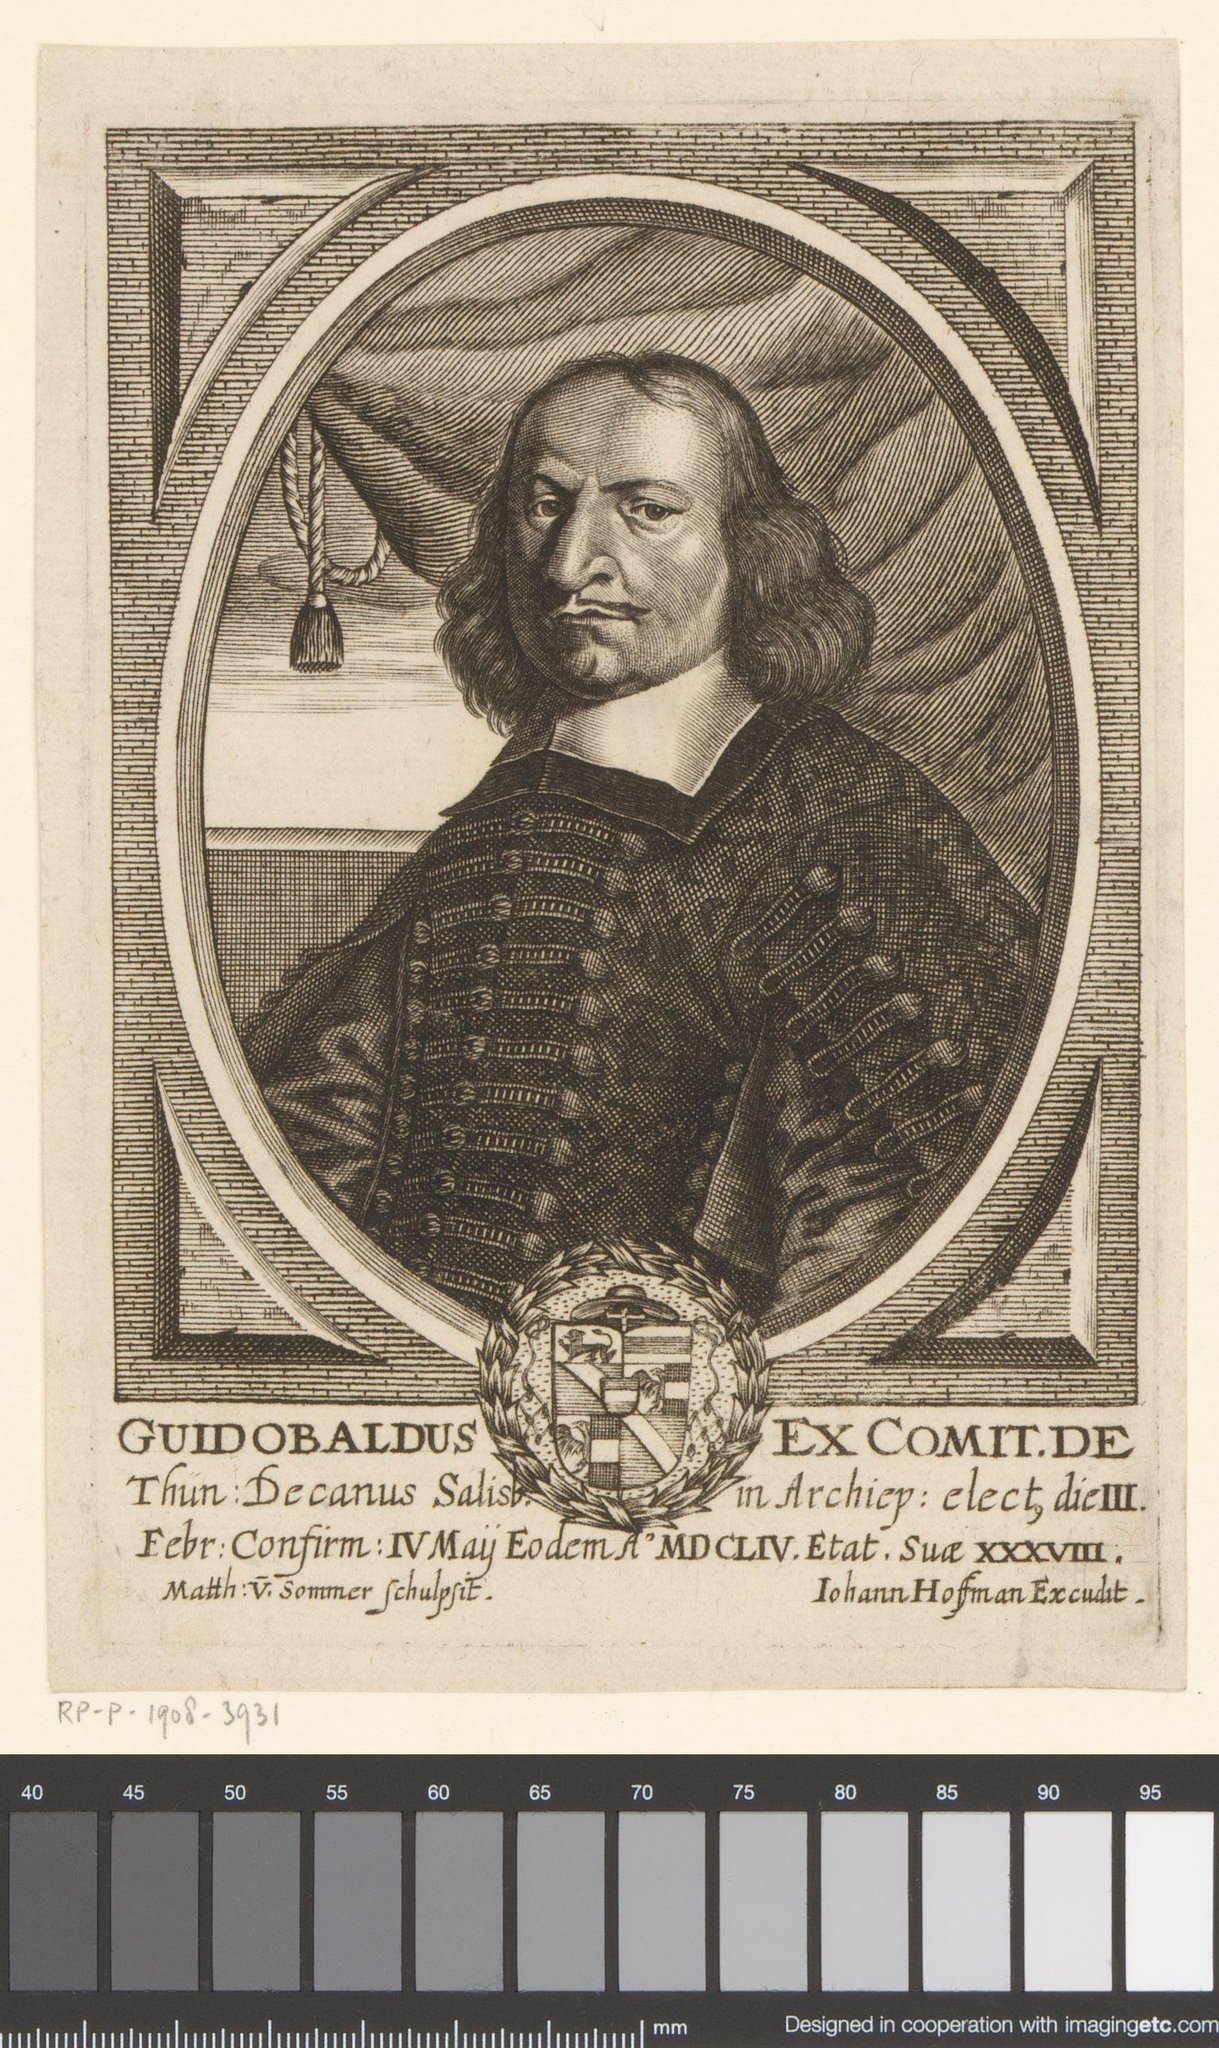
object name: print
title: Portret van Guidobald von Thun und Hohenstein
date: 1654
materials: paper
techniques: engraving, etching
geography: nuremberg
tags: clergyman, archbishop, bishop, etc. (roman catholic), cardinal, historical persons, armorial bearing, heraldry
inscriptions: collector's mark: Lugt 2228